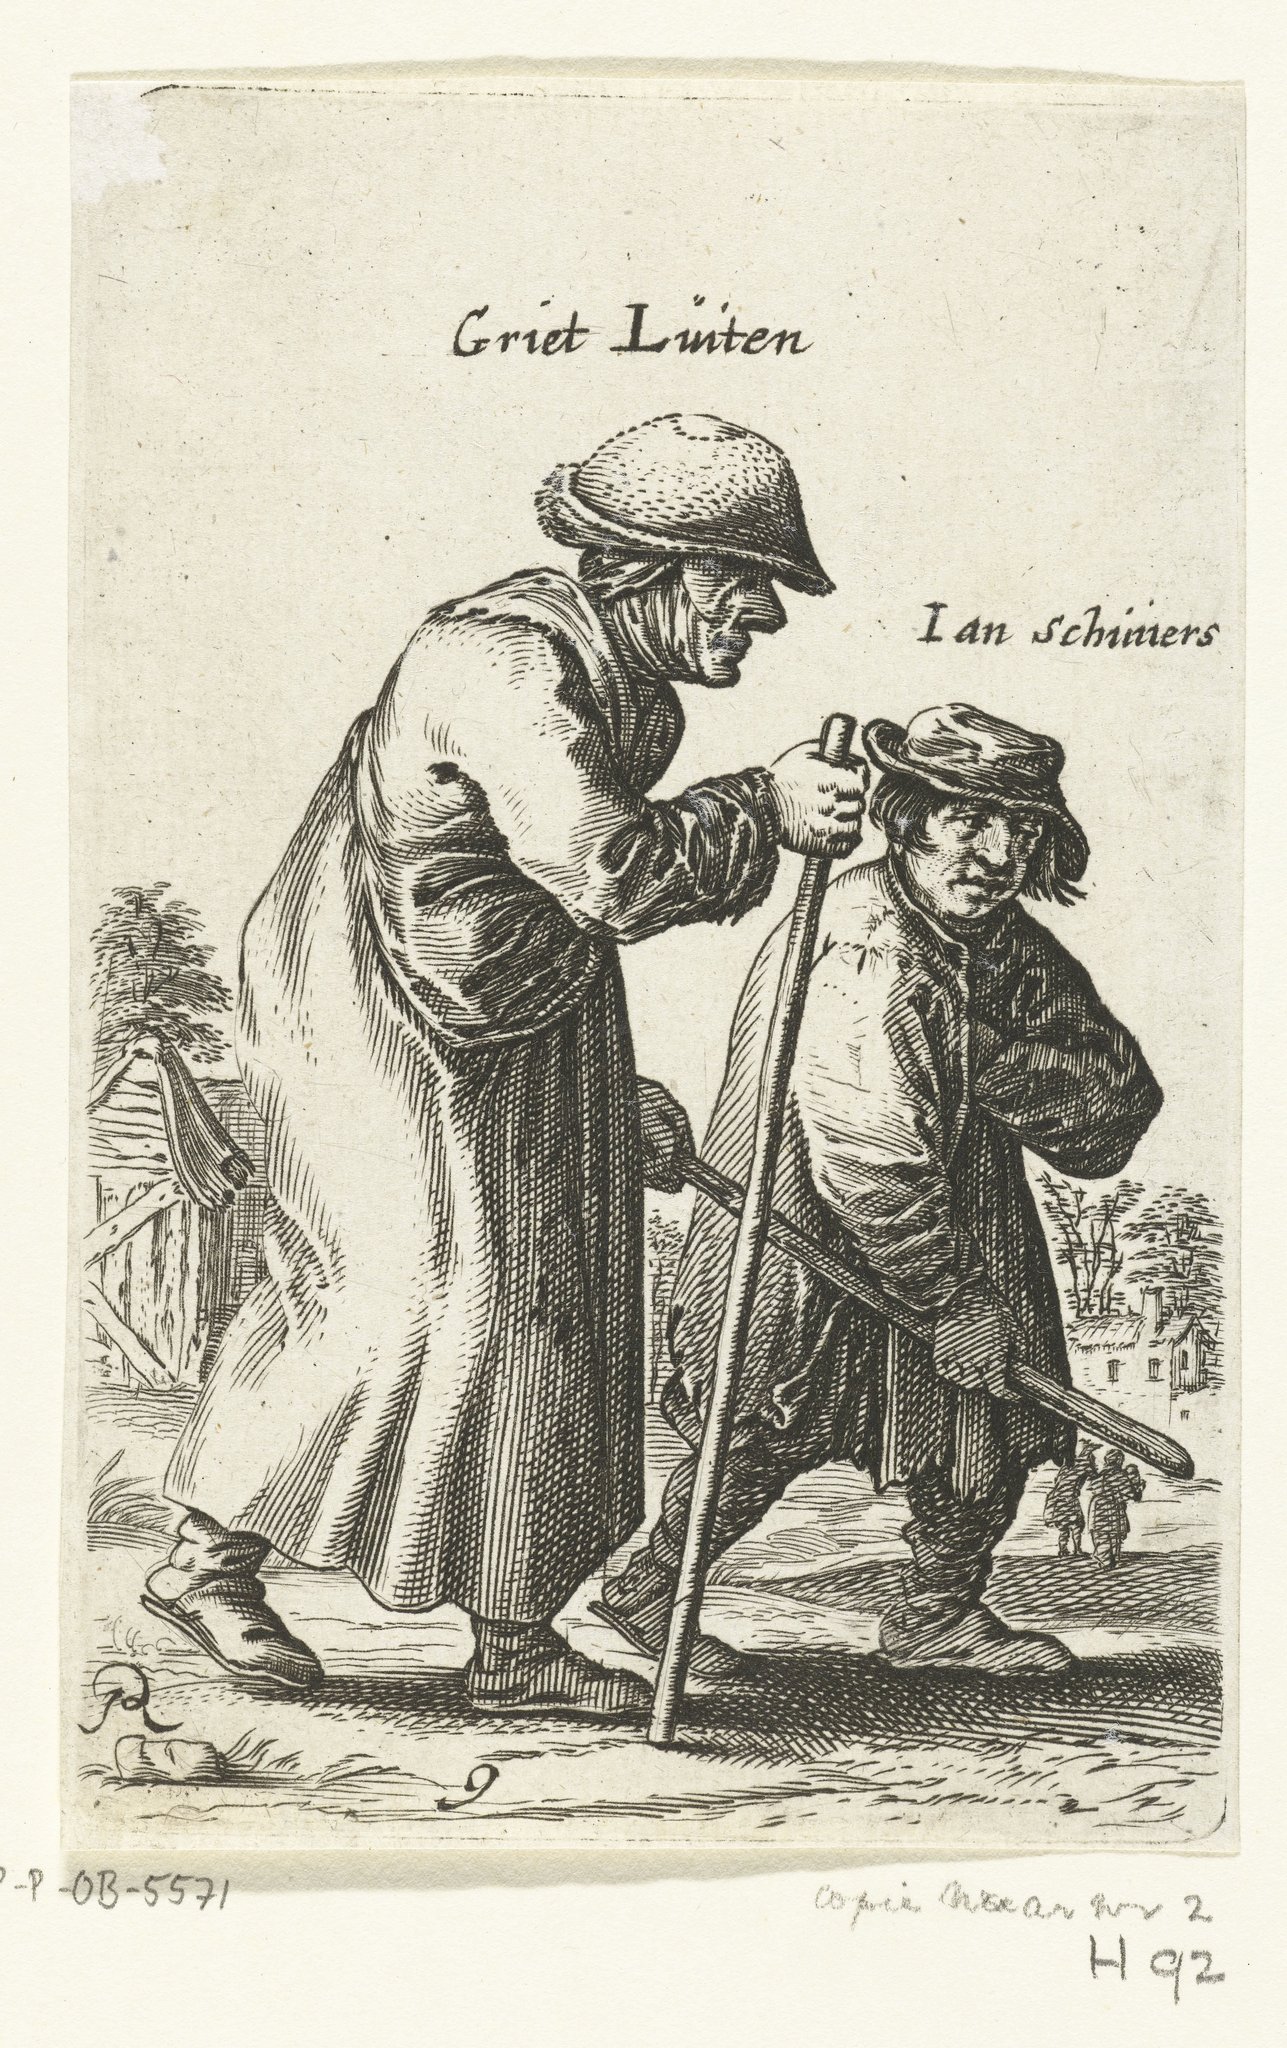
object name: cartoon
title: Oude vrouw met stok geleid door een jongen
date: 1638-1665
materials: paper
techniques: engraving, etching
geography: amsterdam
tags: beggar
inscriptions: collector's mark: Lugt 2228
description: Oude vrouw met stok geleid door een jongen. Op de achtergrond boerderijen. De prent maakt deel uit van een tiendelige serie met voorstellingen van bedelaars en boeren waarin ook verschillende ongelukkige figuren uit de Eerste Engelse Oorlog zijn opgenomen, ca. 1652-1654.